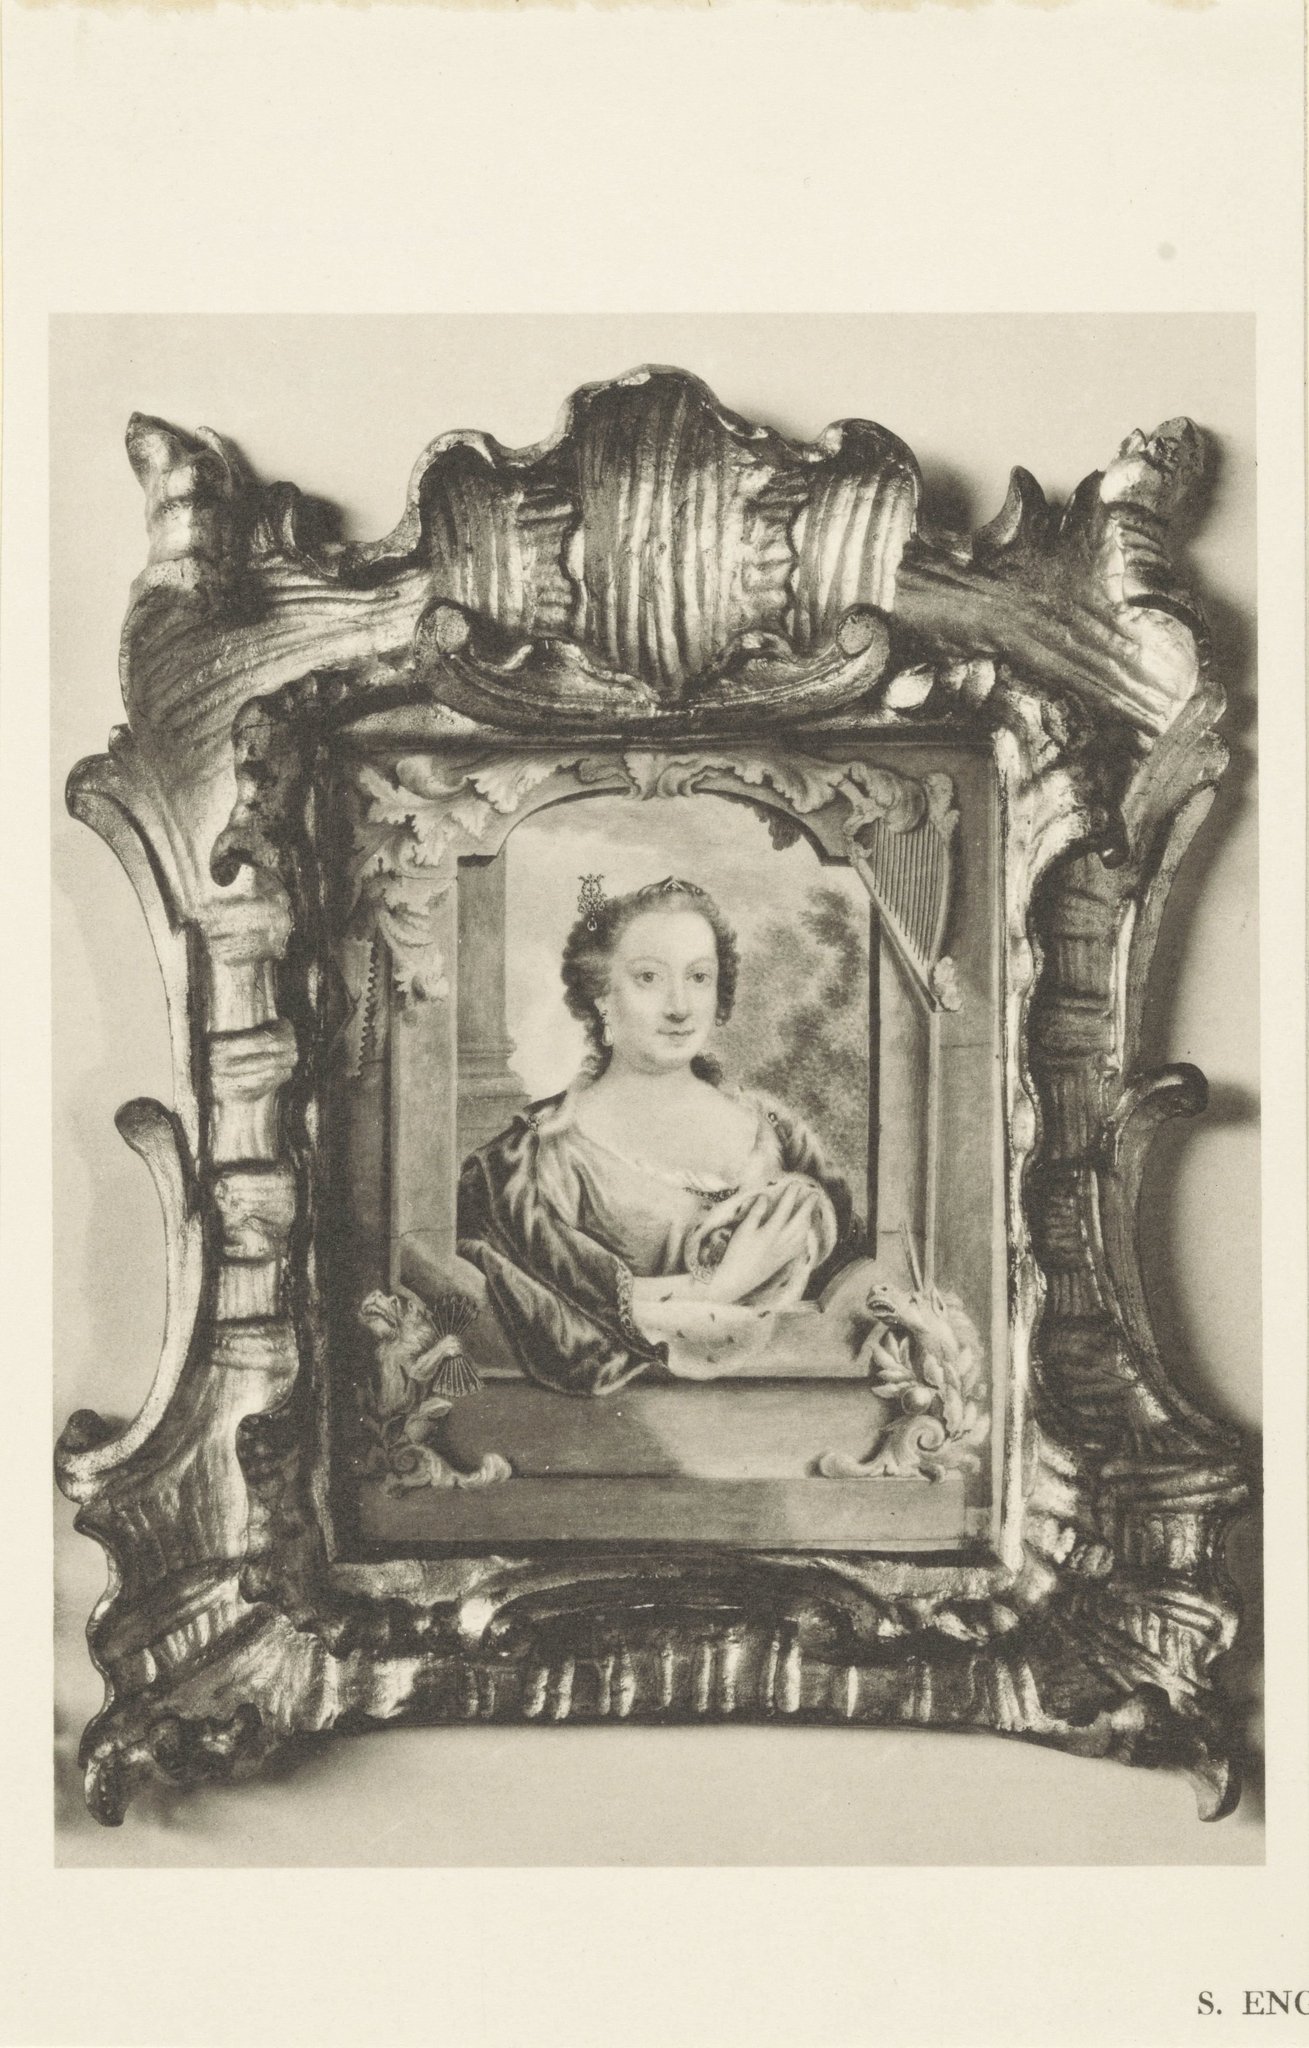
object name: photomechanical print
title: Portret van Anna van Hannover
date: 1850-1949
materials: paper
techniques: photograph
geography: netherlands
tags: anna van hannover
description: Portret van Anna in een geornamenteerde omlijsting.